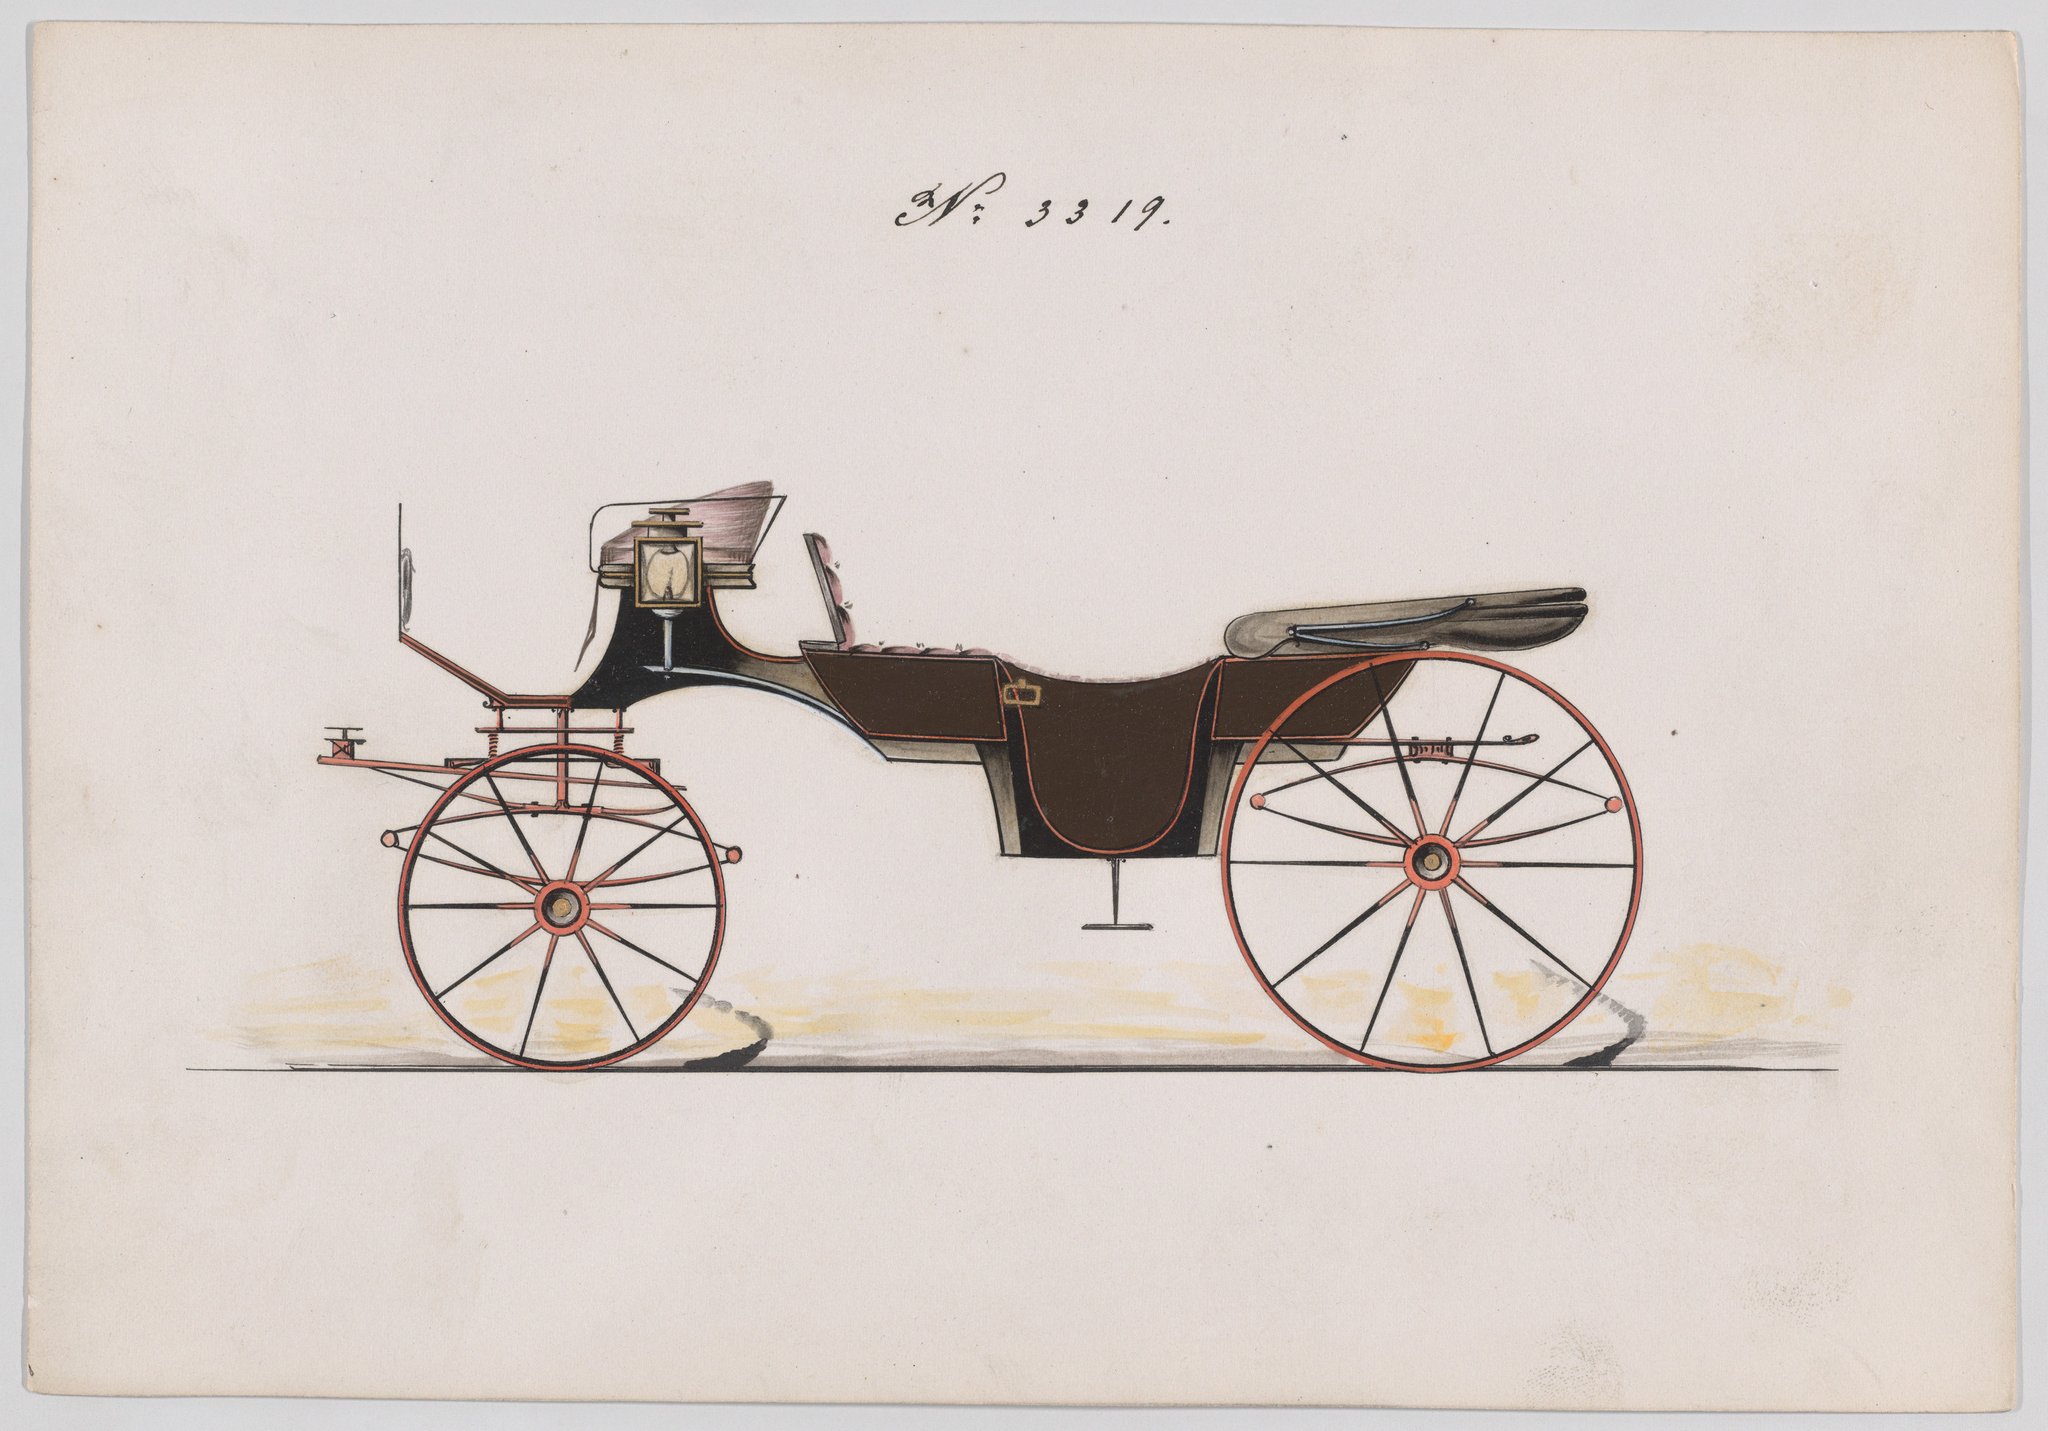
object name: drawing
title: Vis-à-vis/ Brett #3319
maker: brewster & co.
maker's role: manufacturer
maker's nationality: american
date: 1877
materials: gouache, gum arabic, ink, watercolor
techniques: pen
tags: carriages